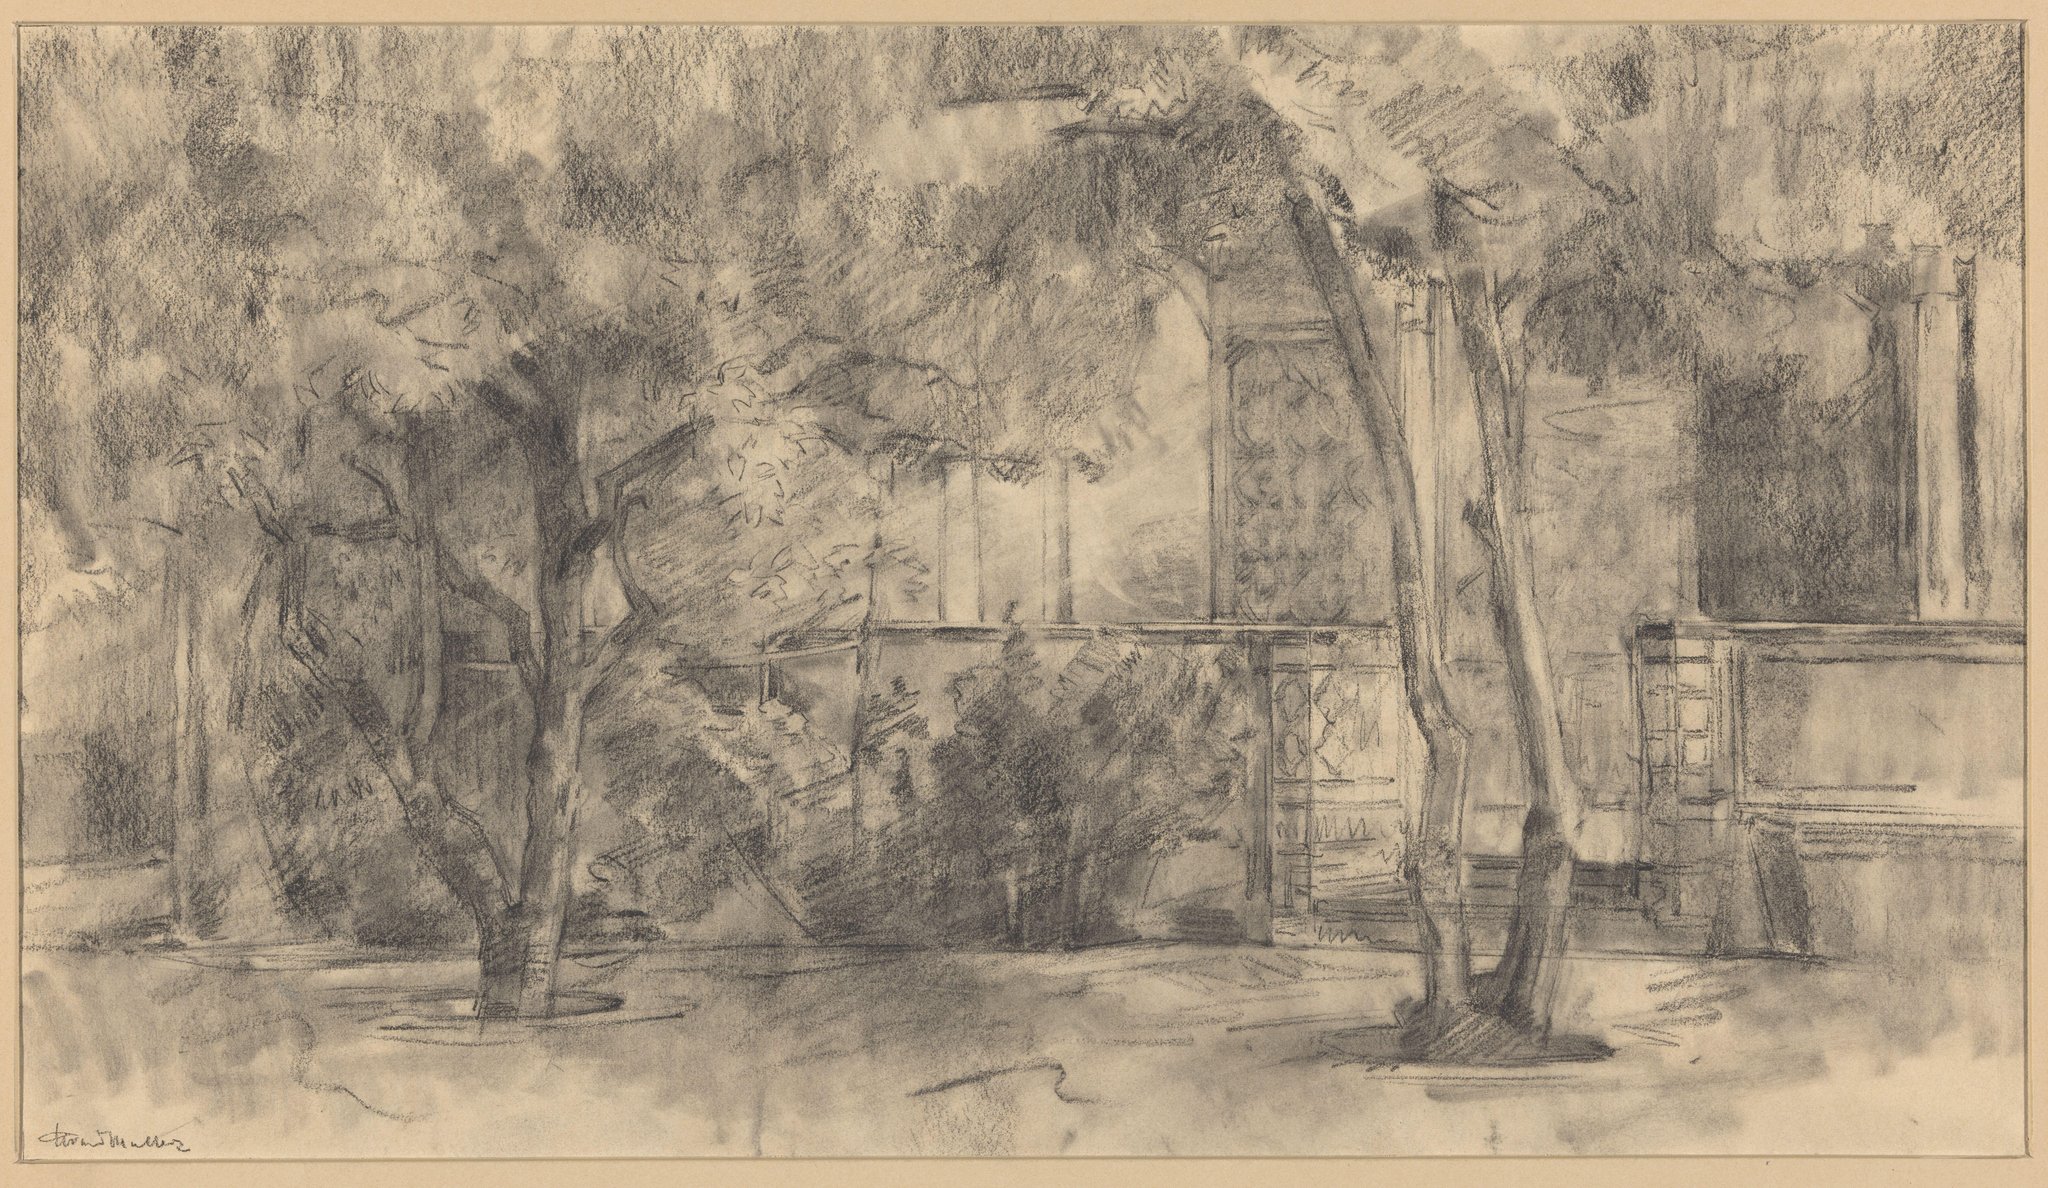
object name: drawing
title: Paviljoen van Karel V in het Koninklijk Paleis te Sevilla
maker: gerard muller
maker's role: draughtsman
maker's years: 1861-1929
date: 1871-1903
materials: chalk, paper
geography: sevilla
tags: palace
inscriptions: label: ‘21. Alcázar . Sevilla/ Pavilloen Karel V.’, collector's mark: Lugt 2228